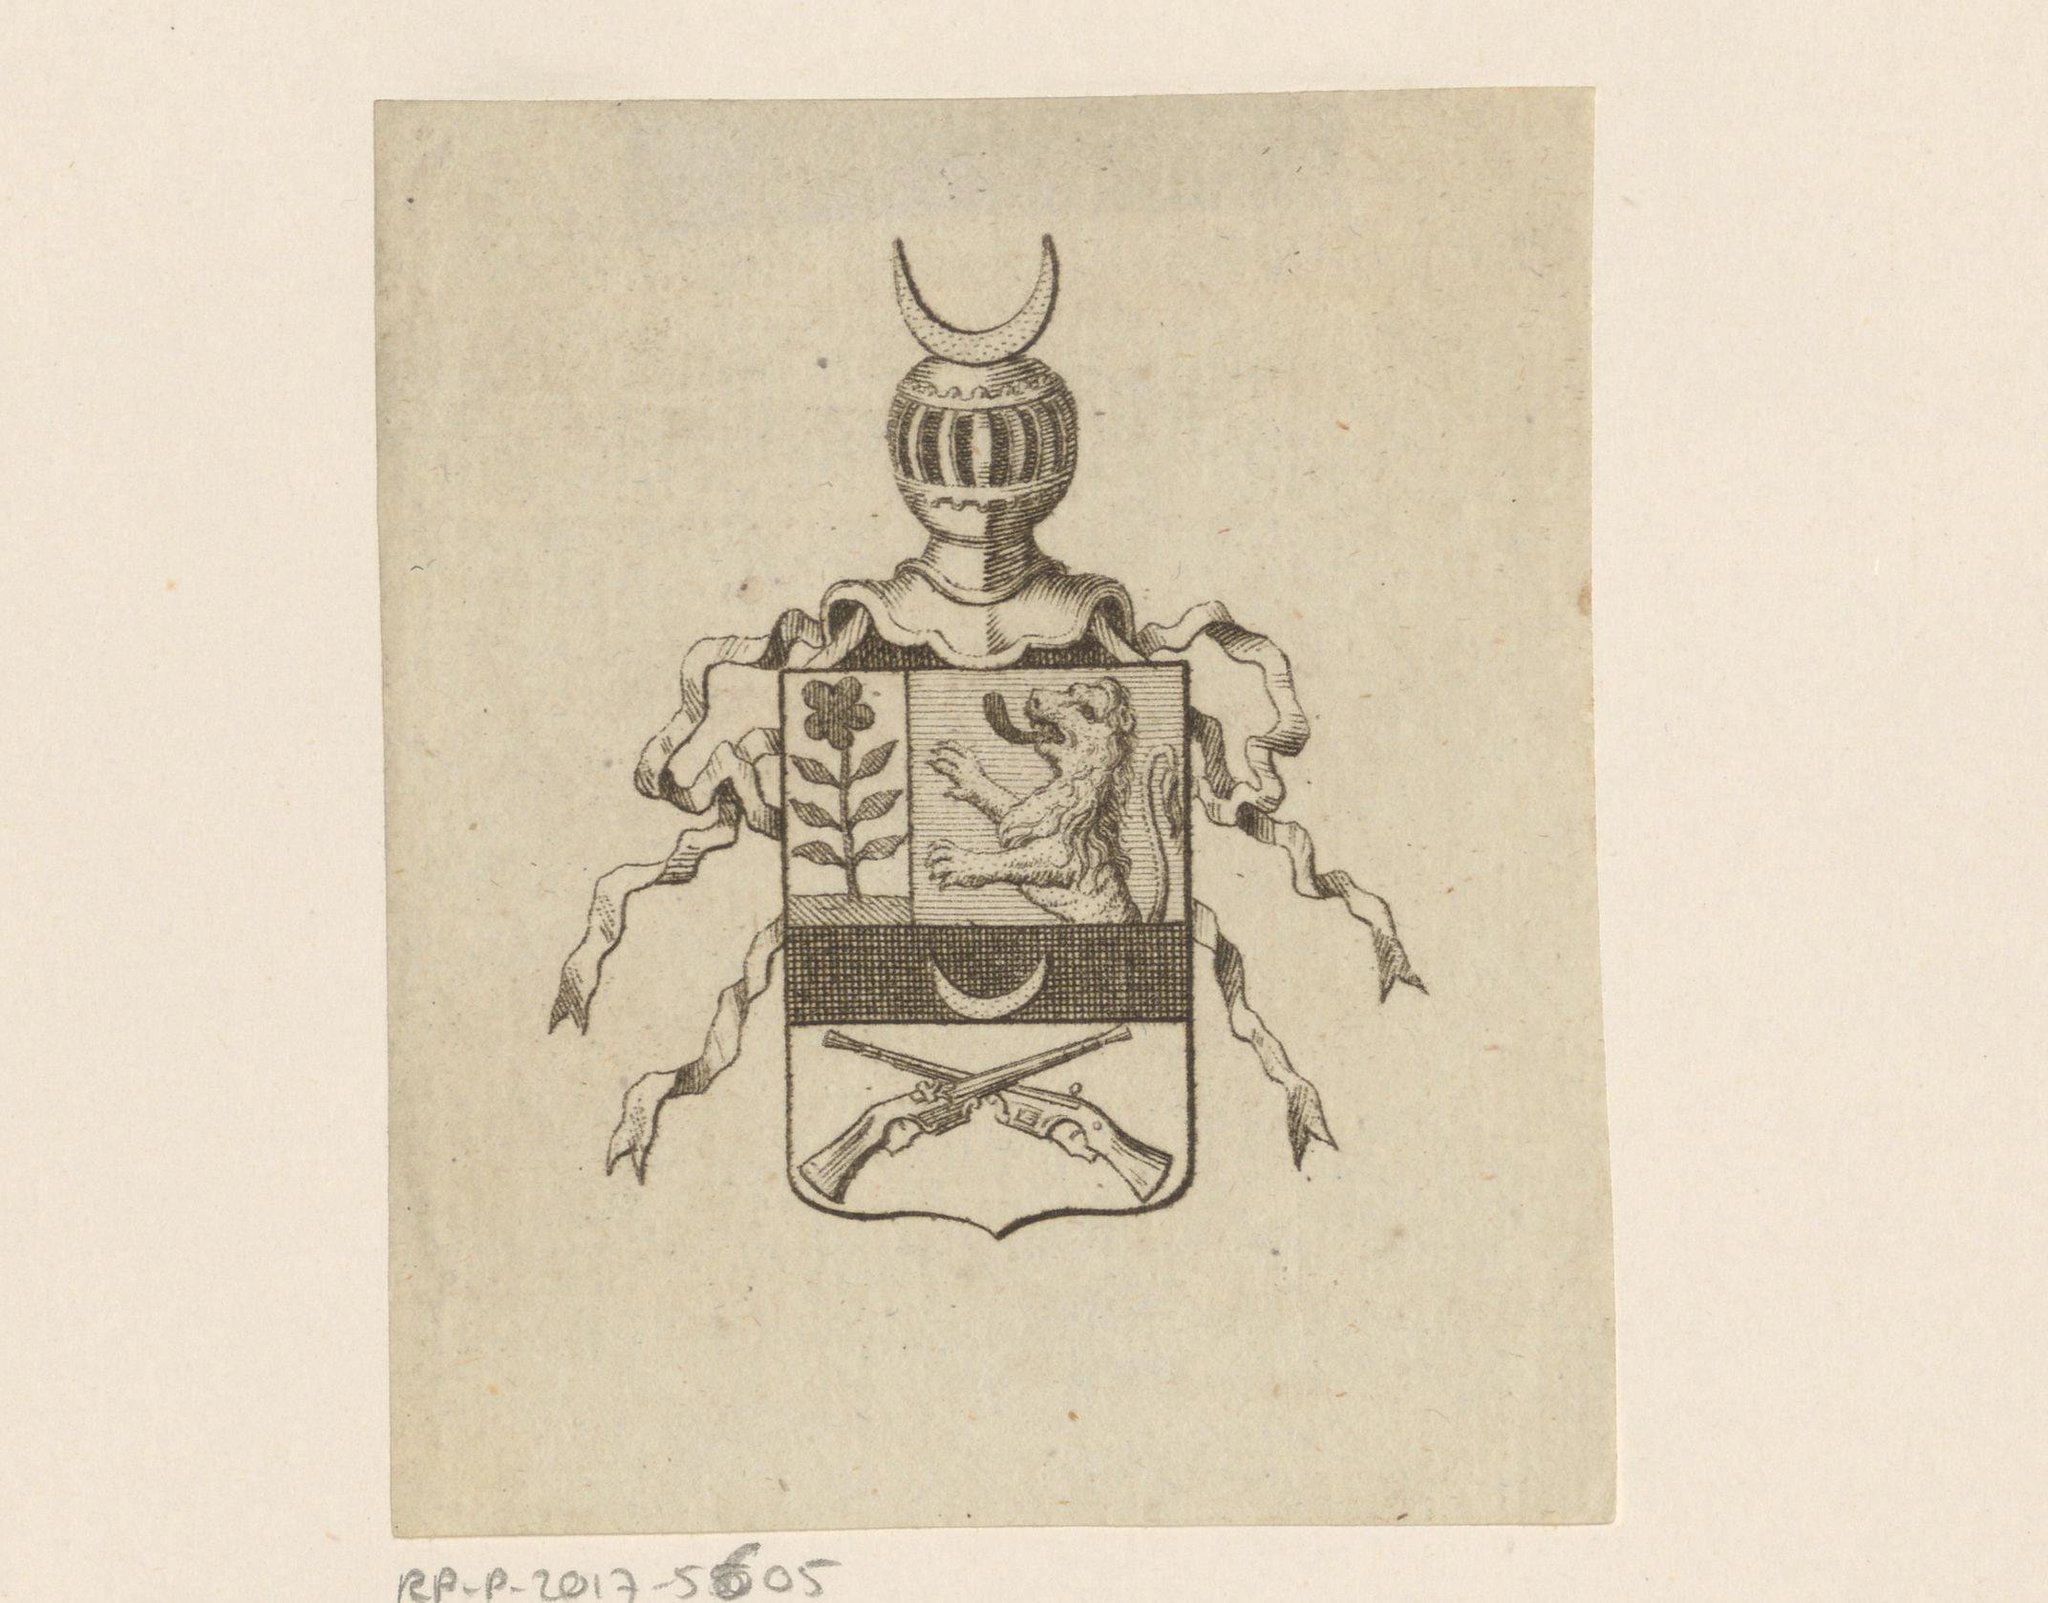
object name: bookplate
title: Ex libris van onbekend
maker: Anonymous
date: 1750-1849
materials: paper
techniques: etching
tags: firearms: rifle, beasts of prey, predatory animals: lion, armorial bearing, heraldry